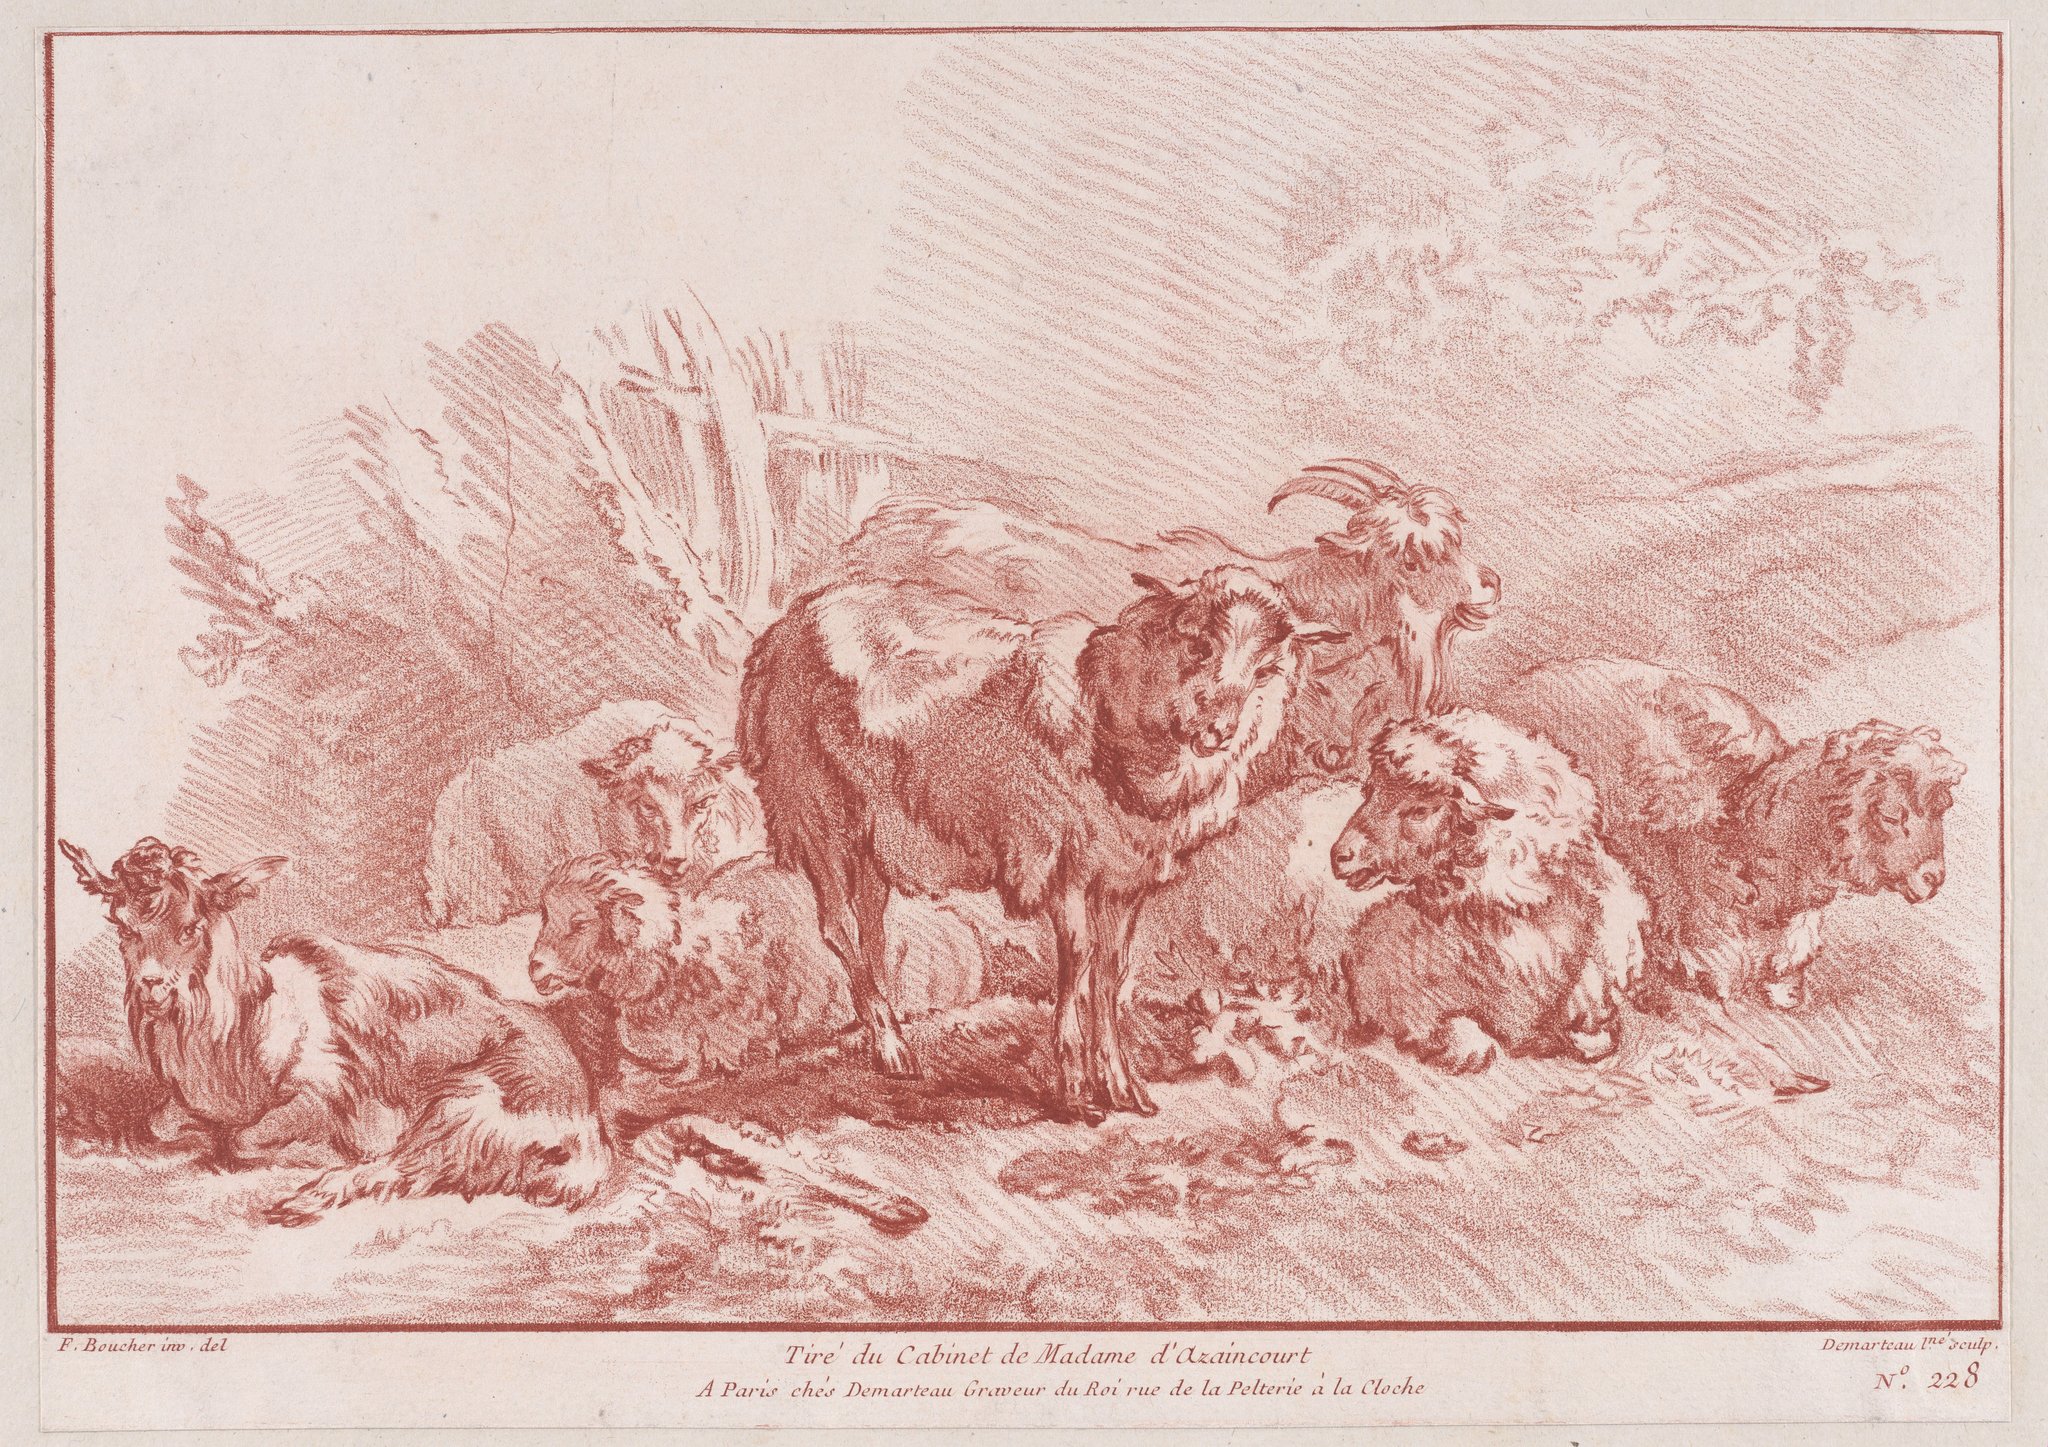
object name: print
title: Animaux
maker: gilles demarteau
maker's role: artist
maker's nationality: french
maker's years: 1722-1776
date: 1701-1800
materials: ink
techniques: printmaking, etching, printing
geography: france